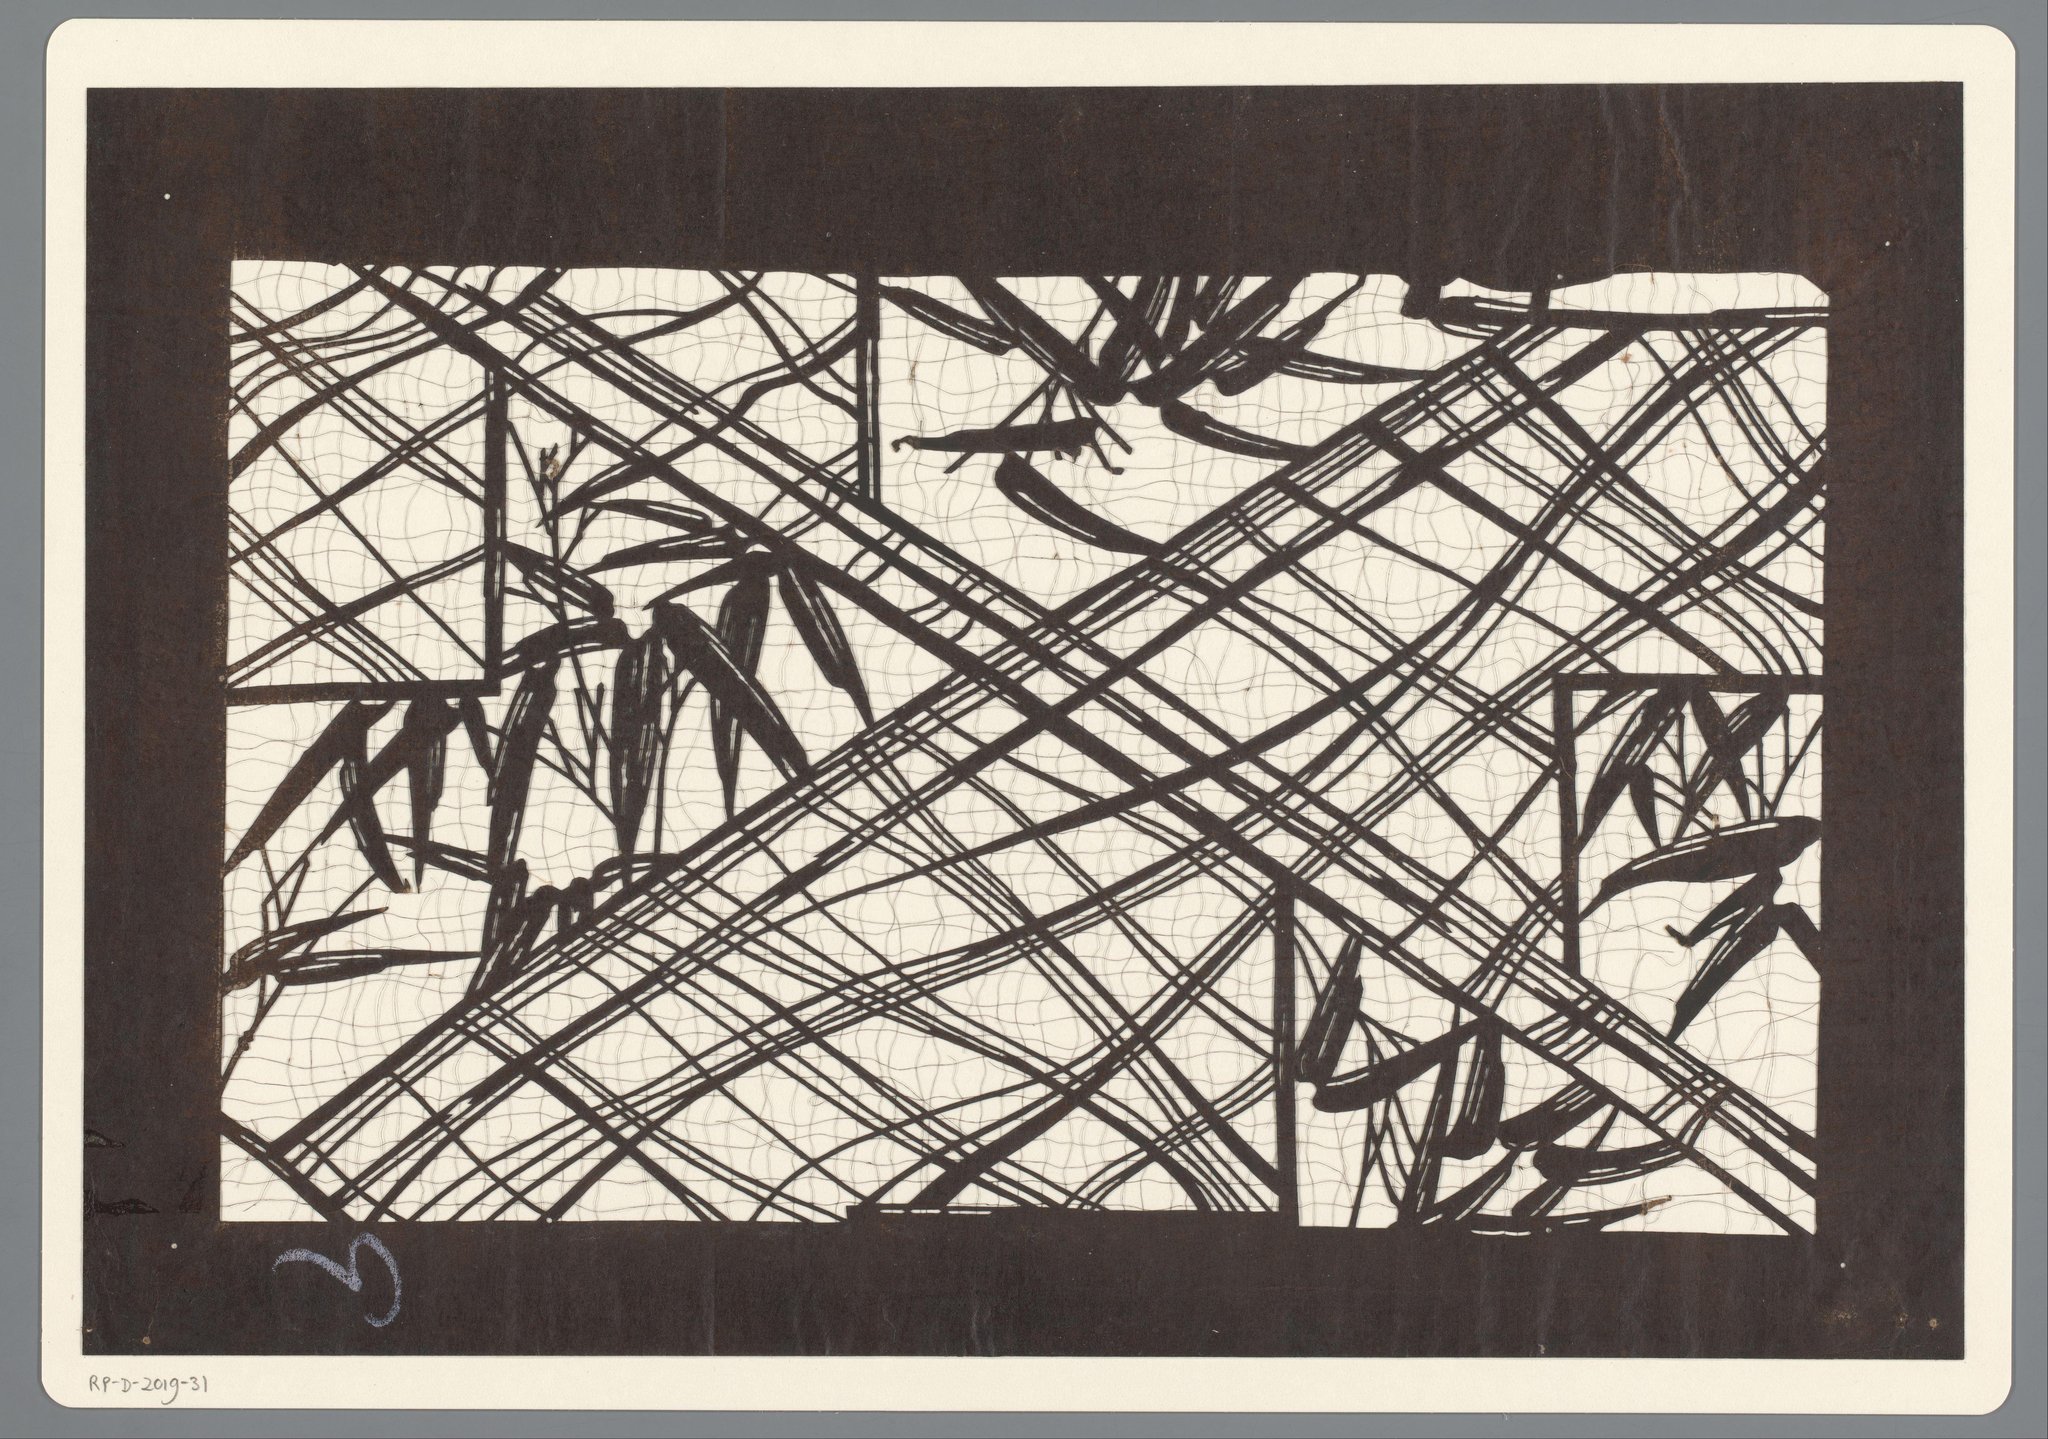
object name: katagami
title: Sjabloon met bamboebladeren en lijnen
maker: Anonymous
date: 1800-1909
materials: paper, silk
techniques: cutting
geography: japan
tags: plants and herbs: bamboo, foliage, tendrils, branches ~ ornament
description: Japanse sjabloon (katagami) met een patroon van bamboebladeren en diagonaal kruisende lijnen.